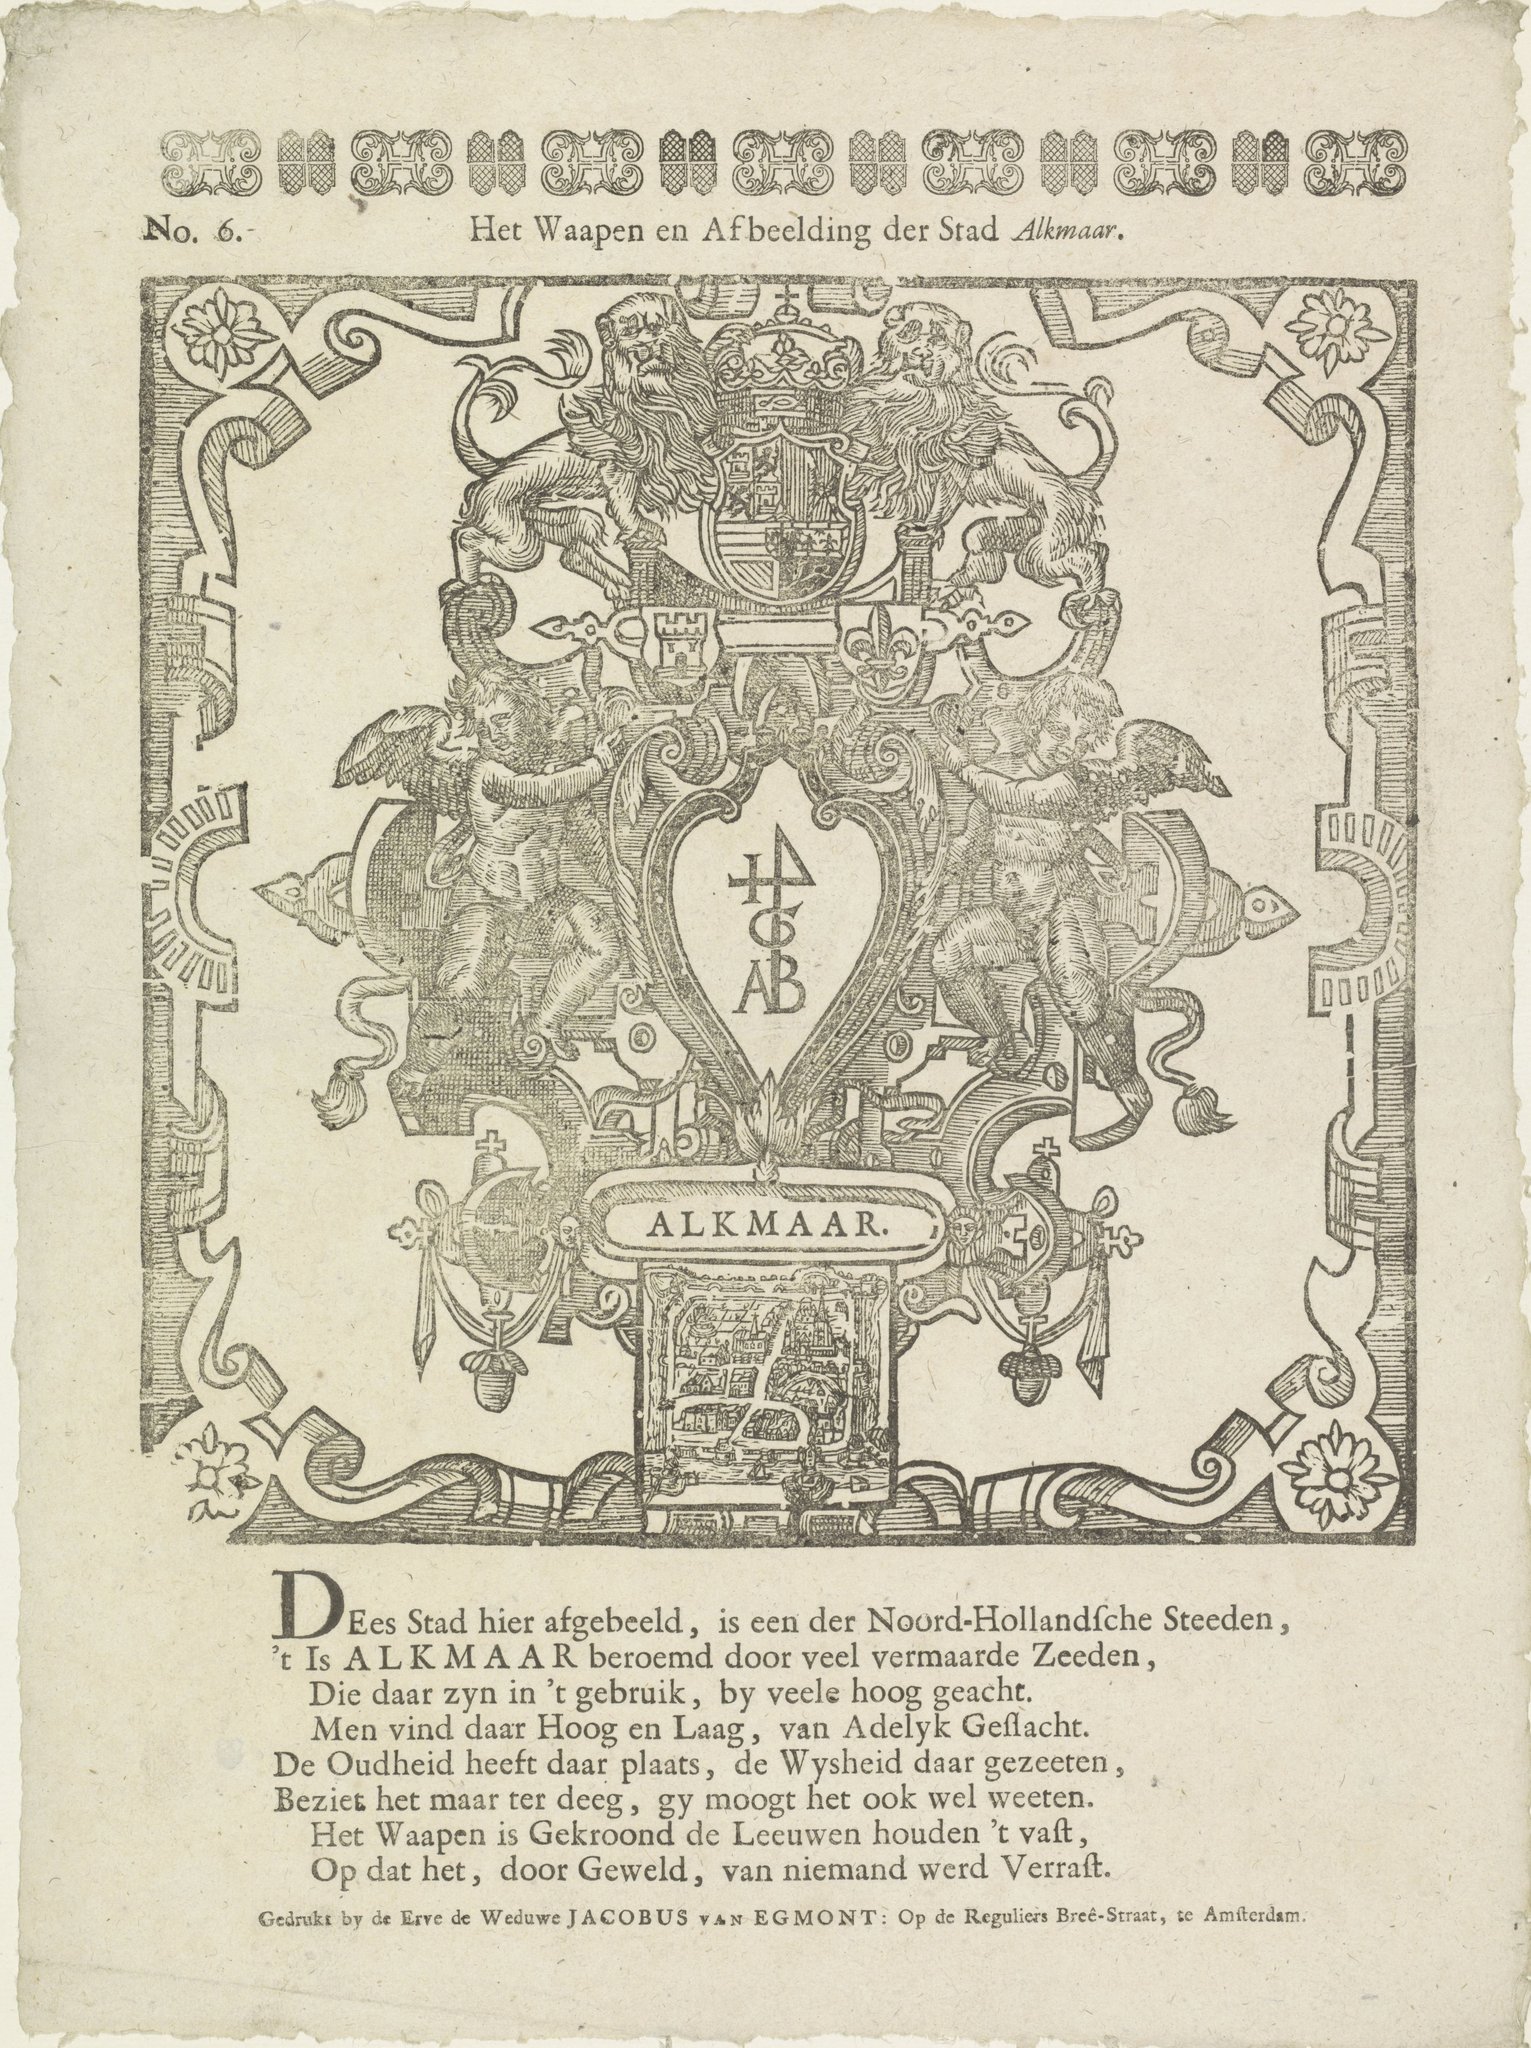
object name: popular print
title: Het waapen en afbeelding der stad Alkmaar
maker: Anonymous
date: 1761-1804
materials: paper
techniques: letterpress printing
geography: netherlands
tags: coat of arms (as symbol of the state, etc.) (+ city; municipal), city-view in general; 'veduta'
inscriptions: collector's mark: Lugt 2760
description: Het wapen van de stad Alkmaar en een zicht op de stad. Geheel omgeven door een sierrand. Onder de voorstelling een achtregelig vers. Genummerd linksboven: No. 6.